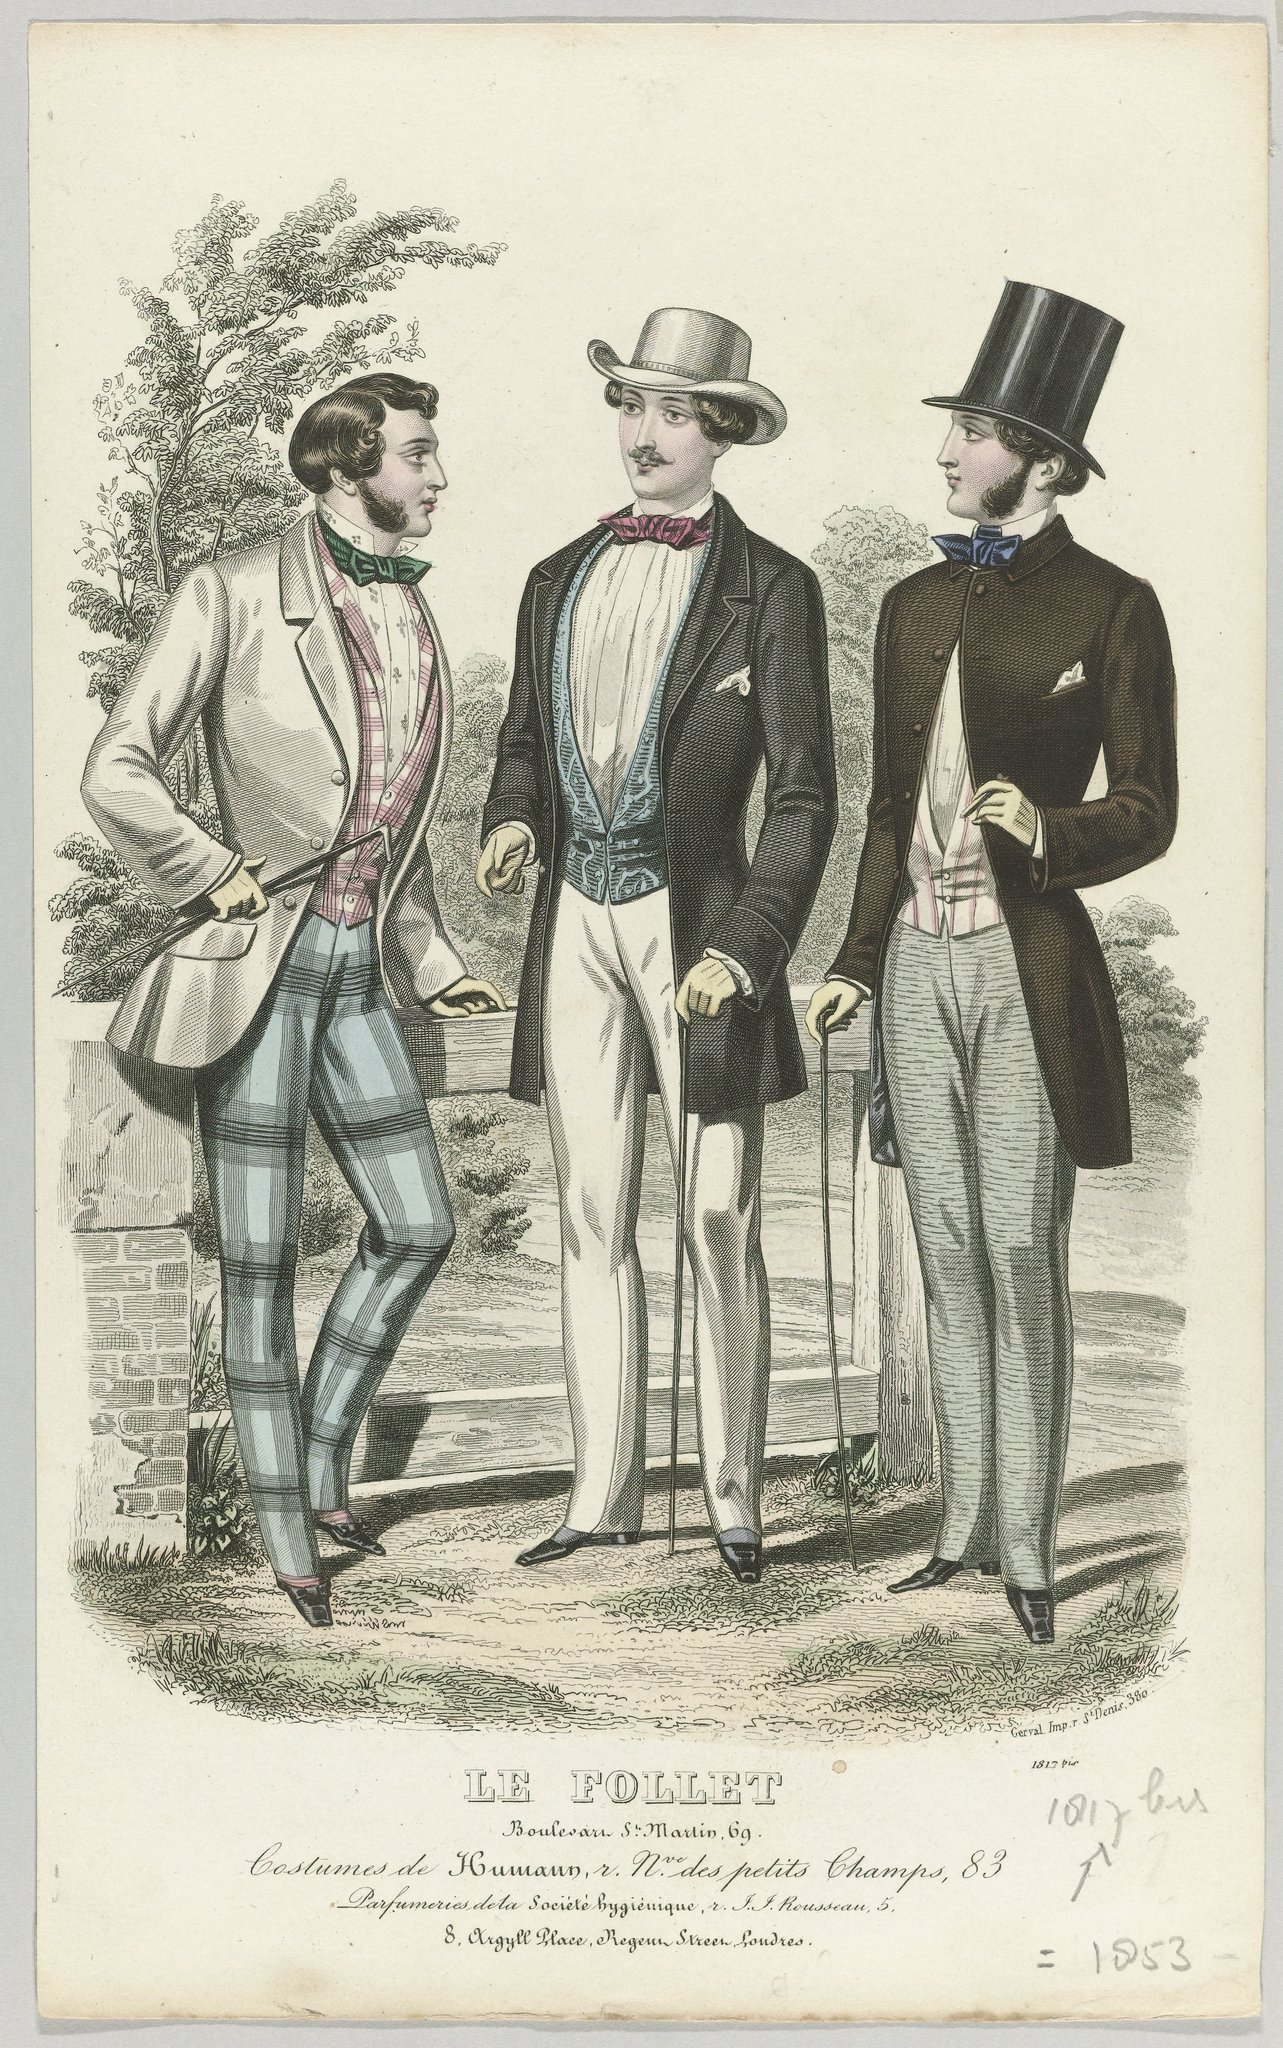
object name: fashion print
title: Le Follet, 1853, No. 1817 bis : Costumes de Humann (...)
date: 1853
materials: paper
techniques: hand coloring, engraving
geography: paris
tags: clothing for the upper part of the body (vest) (+ men's clothes), neck-gear ~ clothing (revers) (+ men's clothes), neck-gear ~ clothing (tie) (+ men's clothes), trousers, breeches, etc. (pantalon) (+ men's clothes), ensembles of pieces of clothing (suit) (+ men's clothes), coat (+ men's clothes), head-gear: hat (+ men's clothes), fashion plates, shoes, sandals (+ men's clothes), gloves, mittens, etc. (+ men's clothes), walking-stick, staff, cane (+ men's clothes)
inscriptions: title: ‘Le Follet’, address: ‘Boulevart S.t Martin, 69 / 8, Argyll Place, Regent Street, Londres.’, caption: ‘Costumes de Humann, r. N.ve des petits Champs, 83. Parfumeries de la Société hygiénique, r. J.J. Rousseau, 5.’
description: Drie mannen met wandelstokken bij een hek. Volgens het onderschrift dragen zij kostuums van Humann. Hieronder een regel reclametekst voor verschillende producten. Prent uit het modetijdschrift Le Follet Courrier des Salons (novembre 1829- octobre 1882).